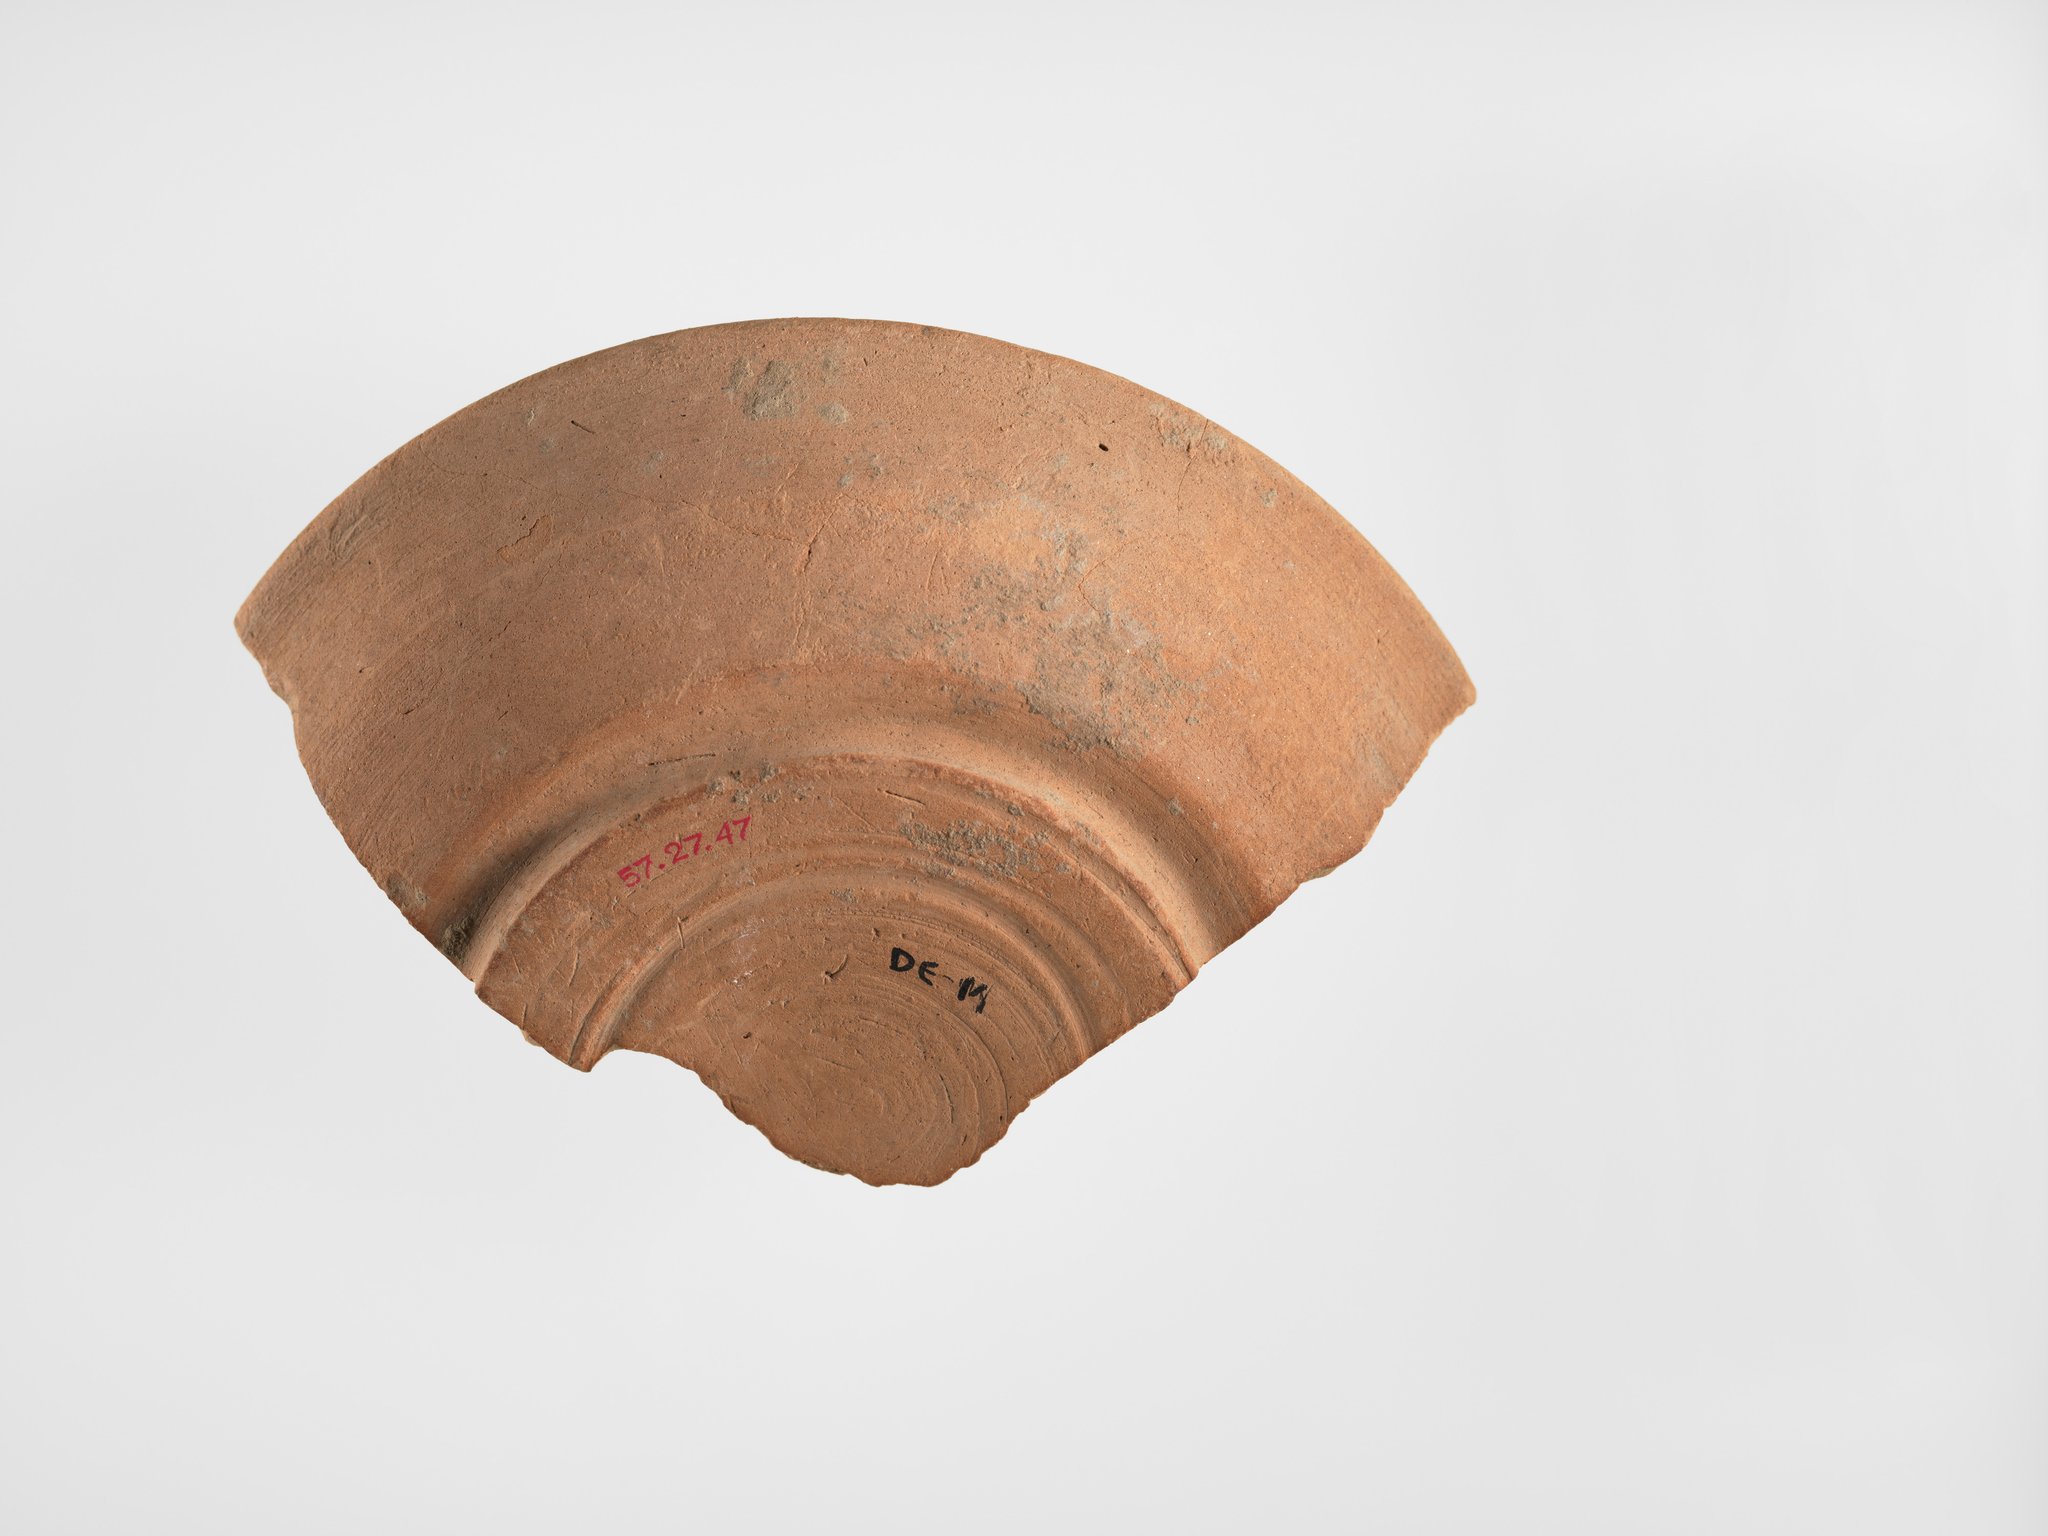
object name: bowl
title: Bowl sherd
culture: assyrian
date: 800-601 BCE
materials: ceramic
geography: mesopotamia